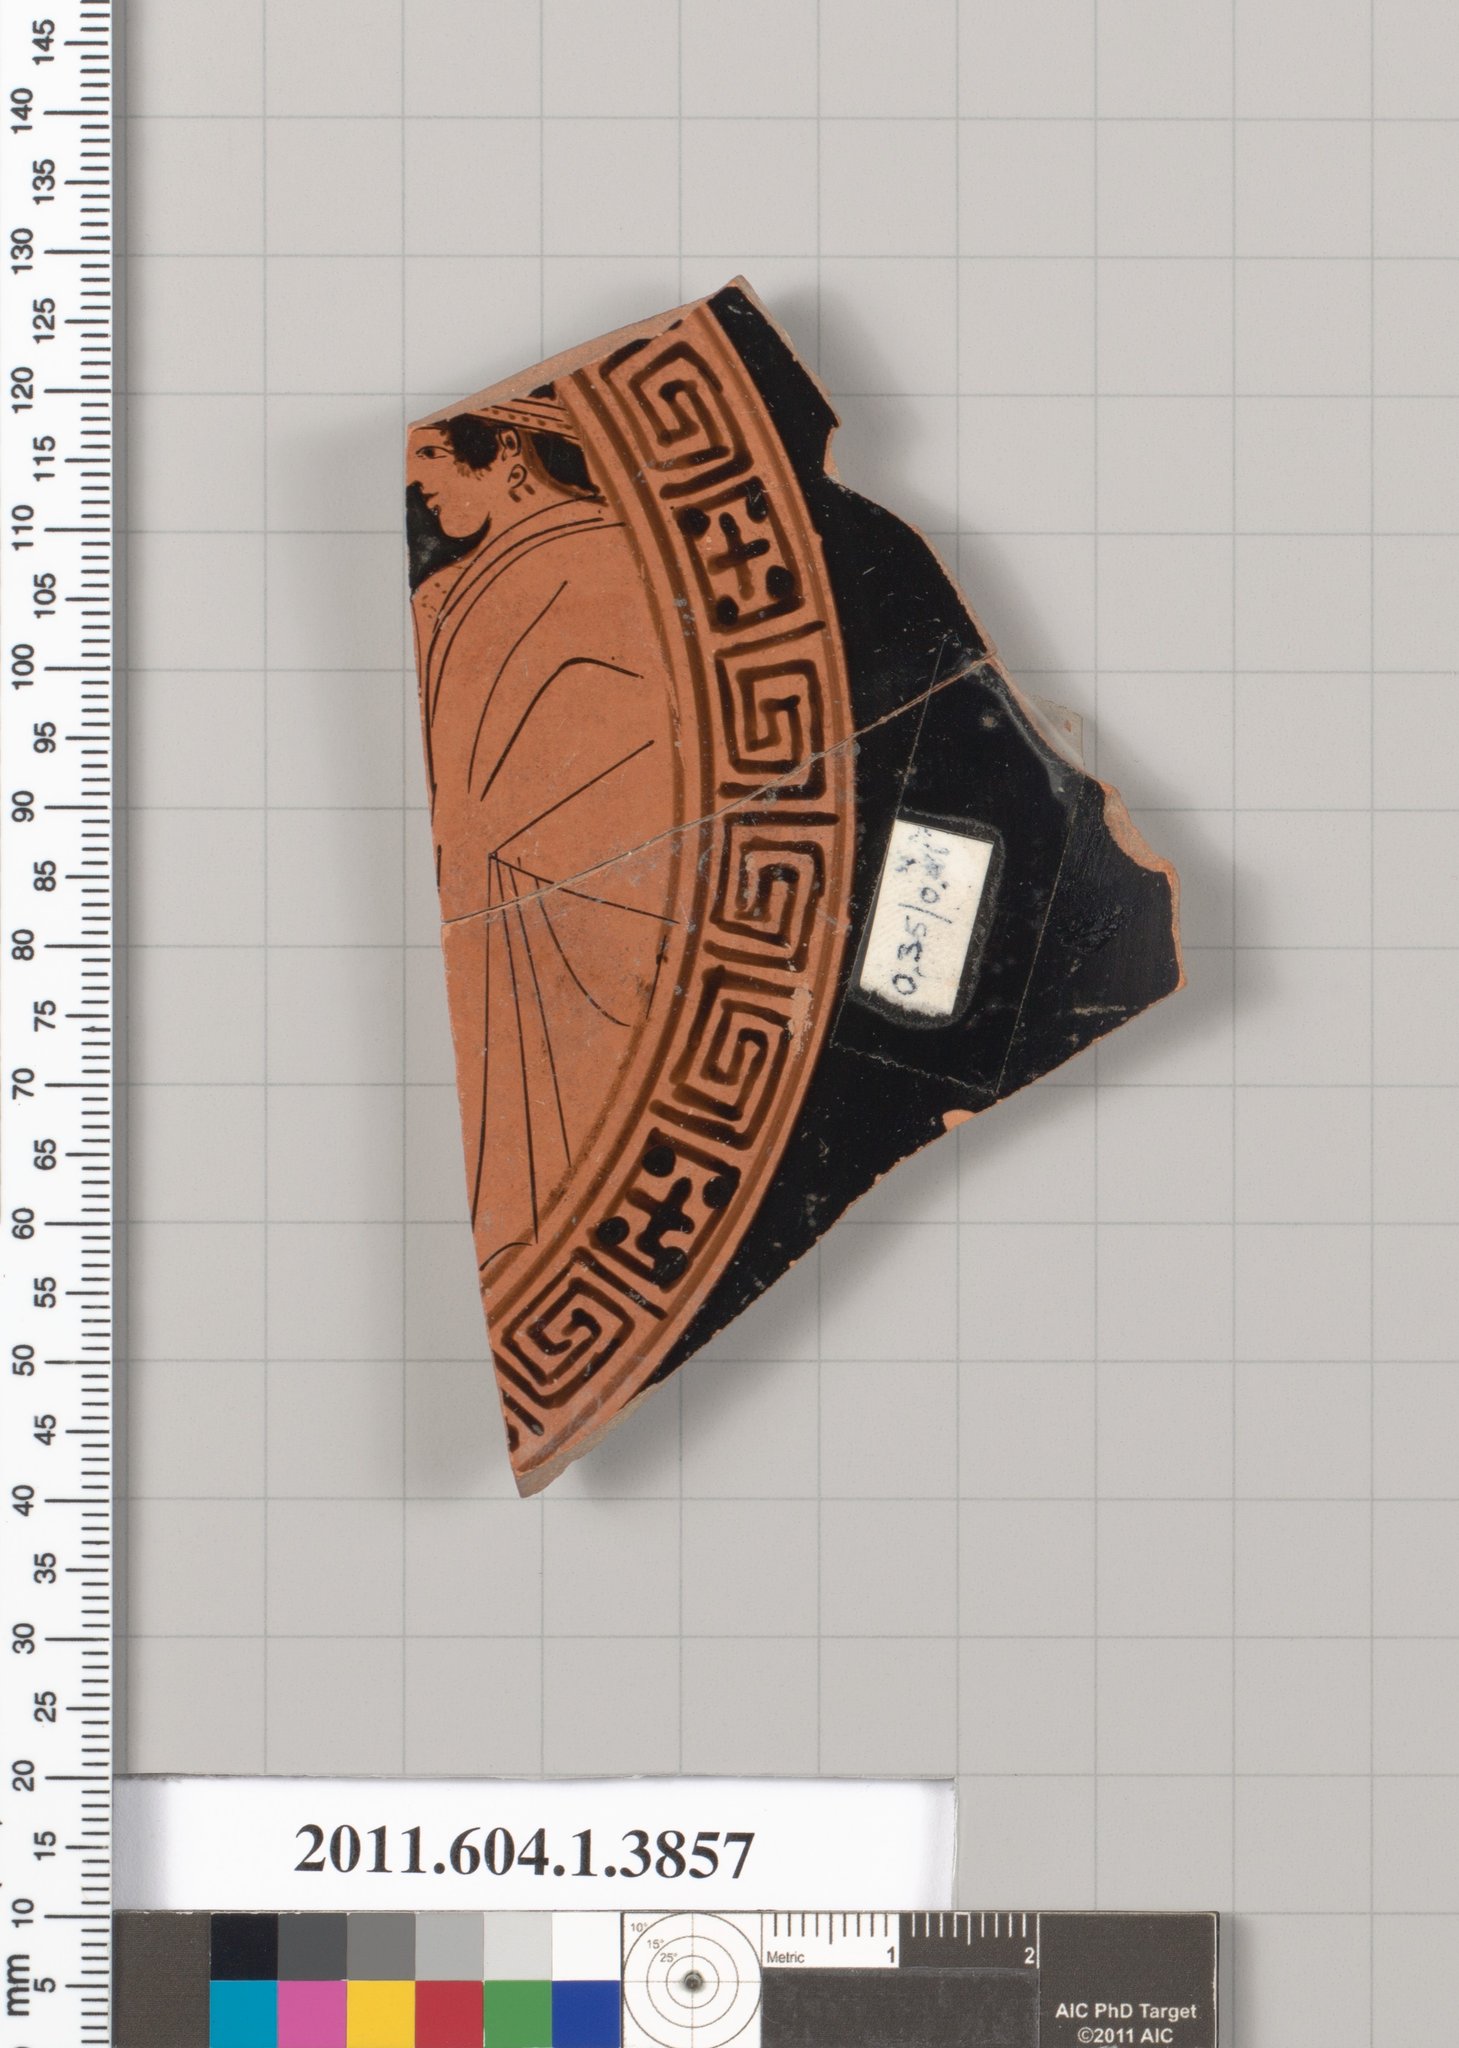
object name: kylix fragment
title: Terracotta fragment of a kylix (drinking cup)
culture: greek, attic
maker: sabouroff painter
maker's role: artist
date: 467-435 BCE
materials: terracotta